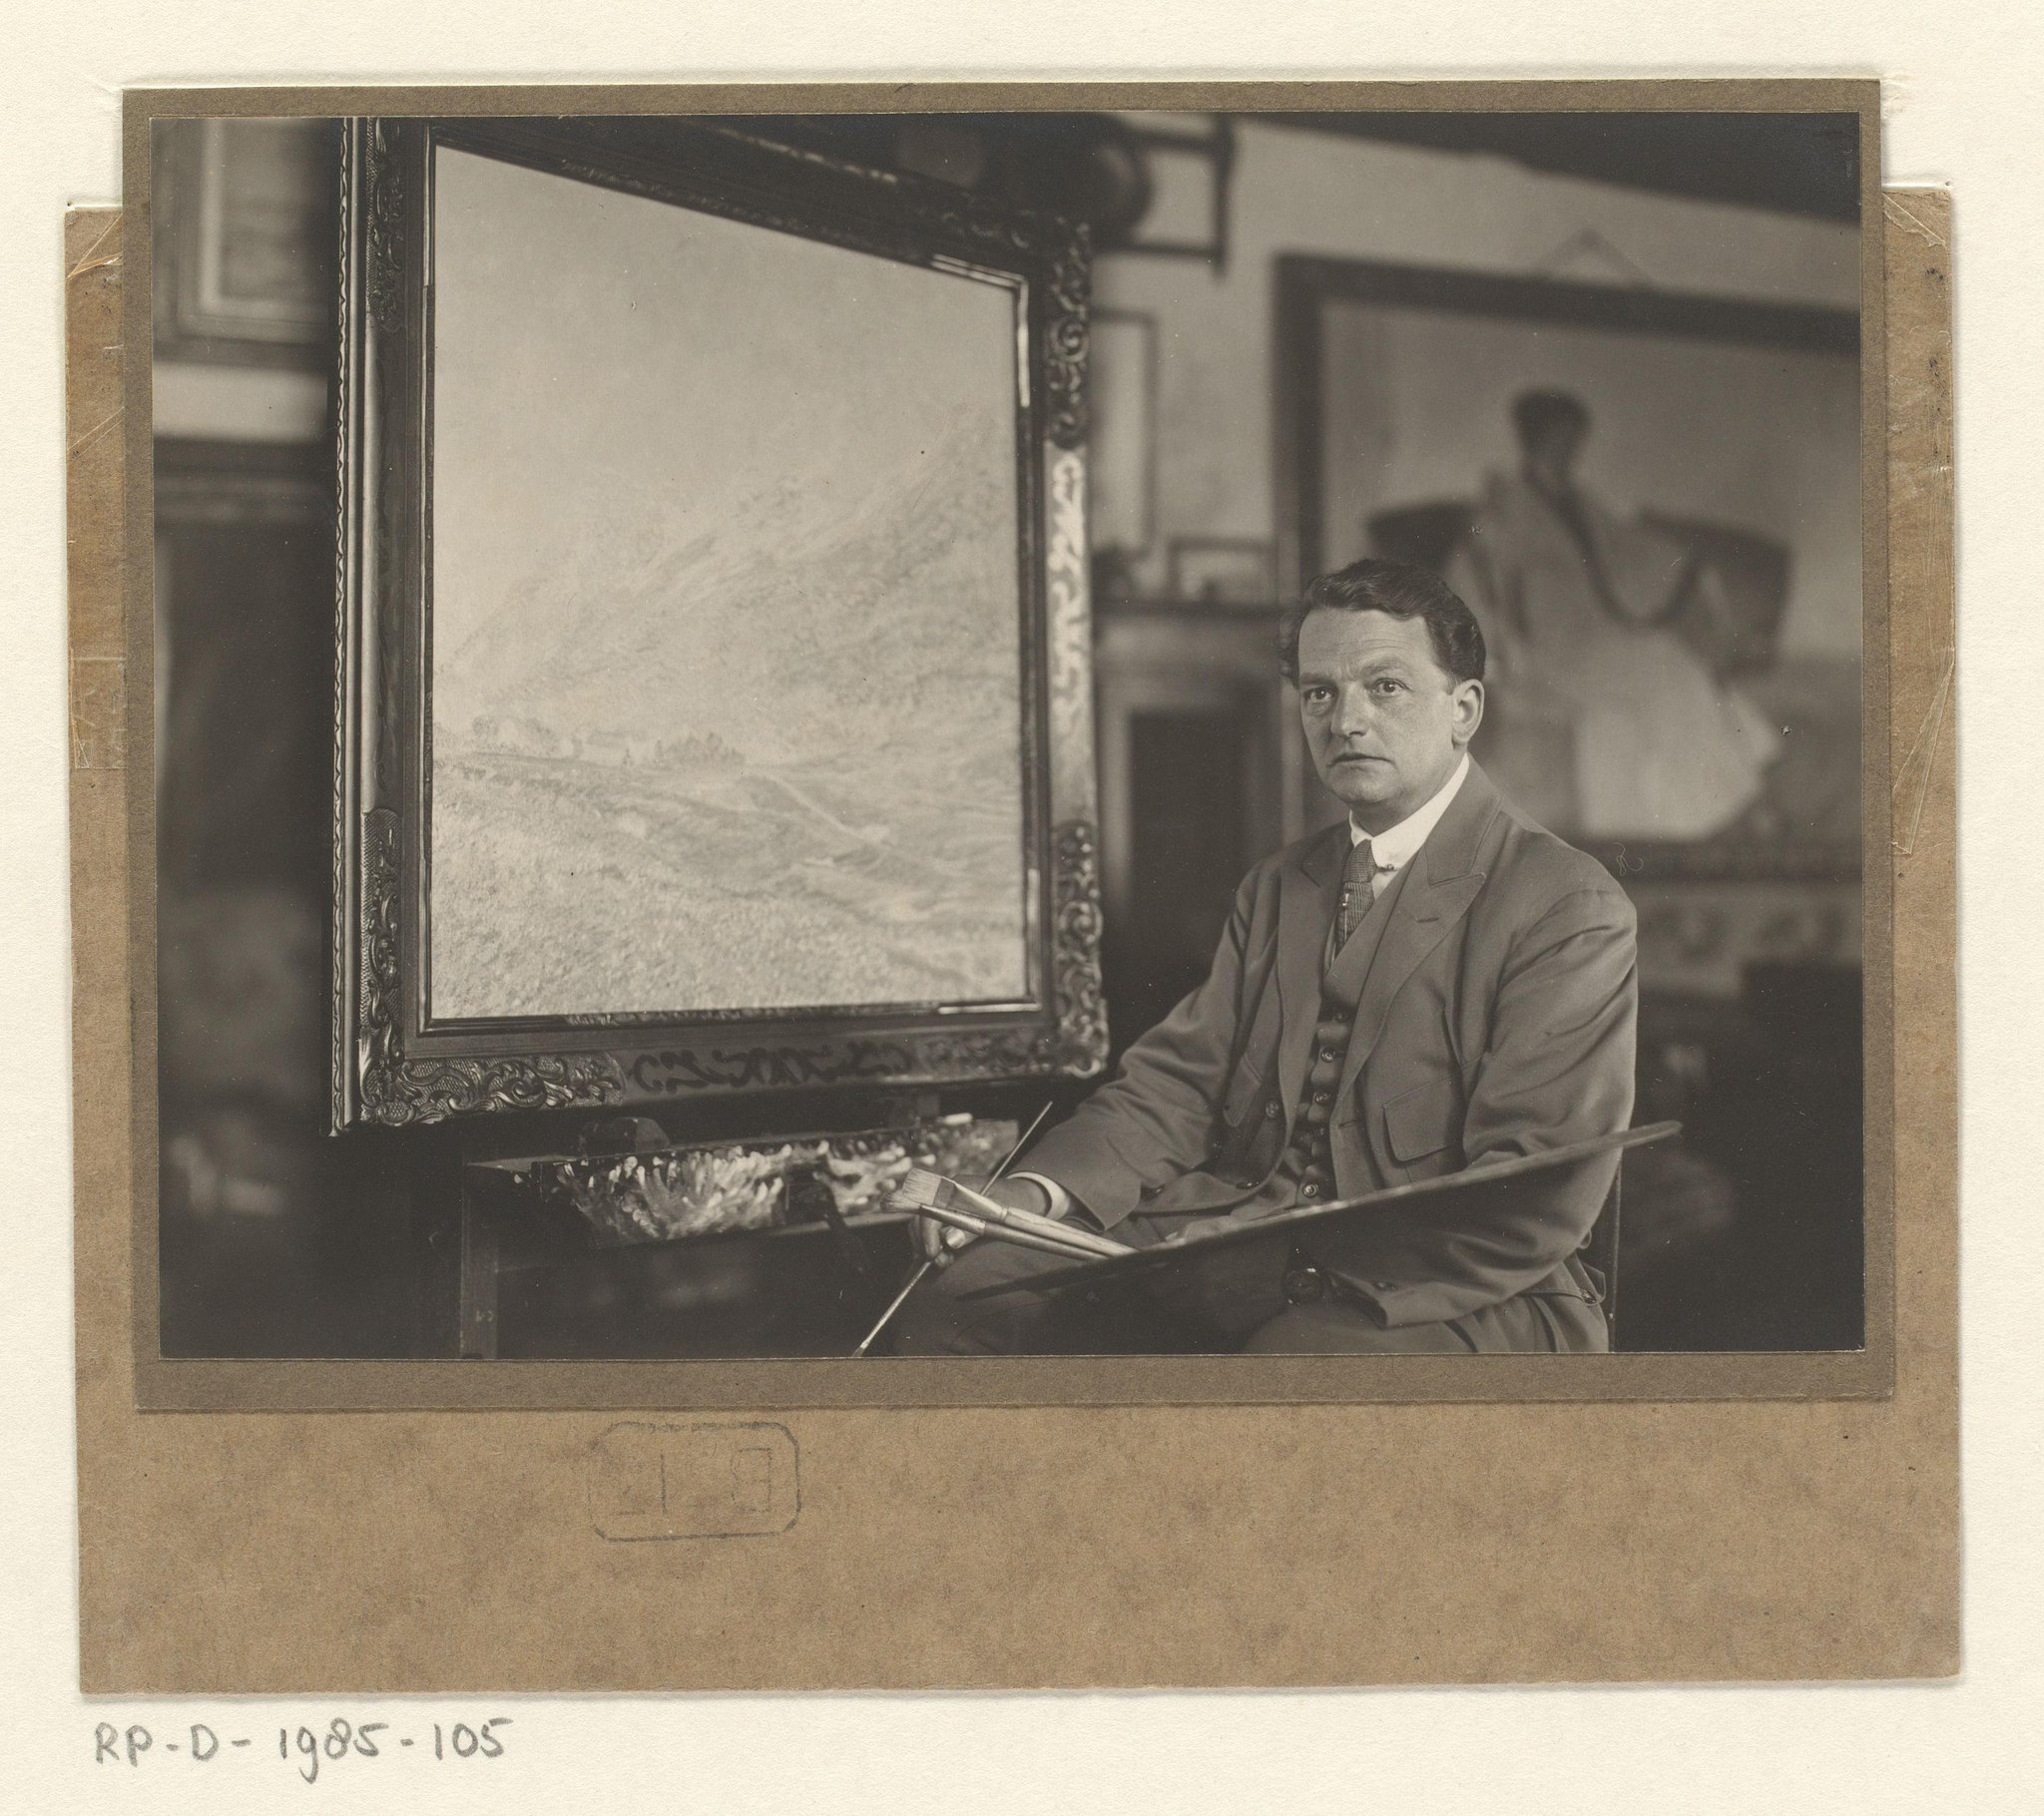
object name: photograph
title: Portret van Jaap Dooijewaard in zijn atelier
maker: Anonymous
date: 1910-1940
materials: paper, cardboard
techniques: gelatin silver print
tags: amsterdam, painter, draughtsman, jaap dooijewaard, historical persons, artist at work, in his workshop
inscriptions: stamp: ‘B[...]’, inscription: ‘Jaap/ Dooijewaard’